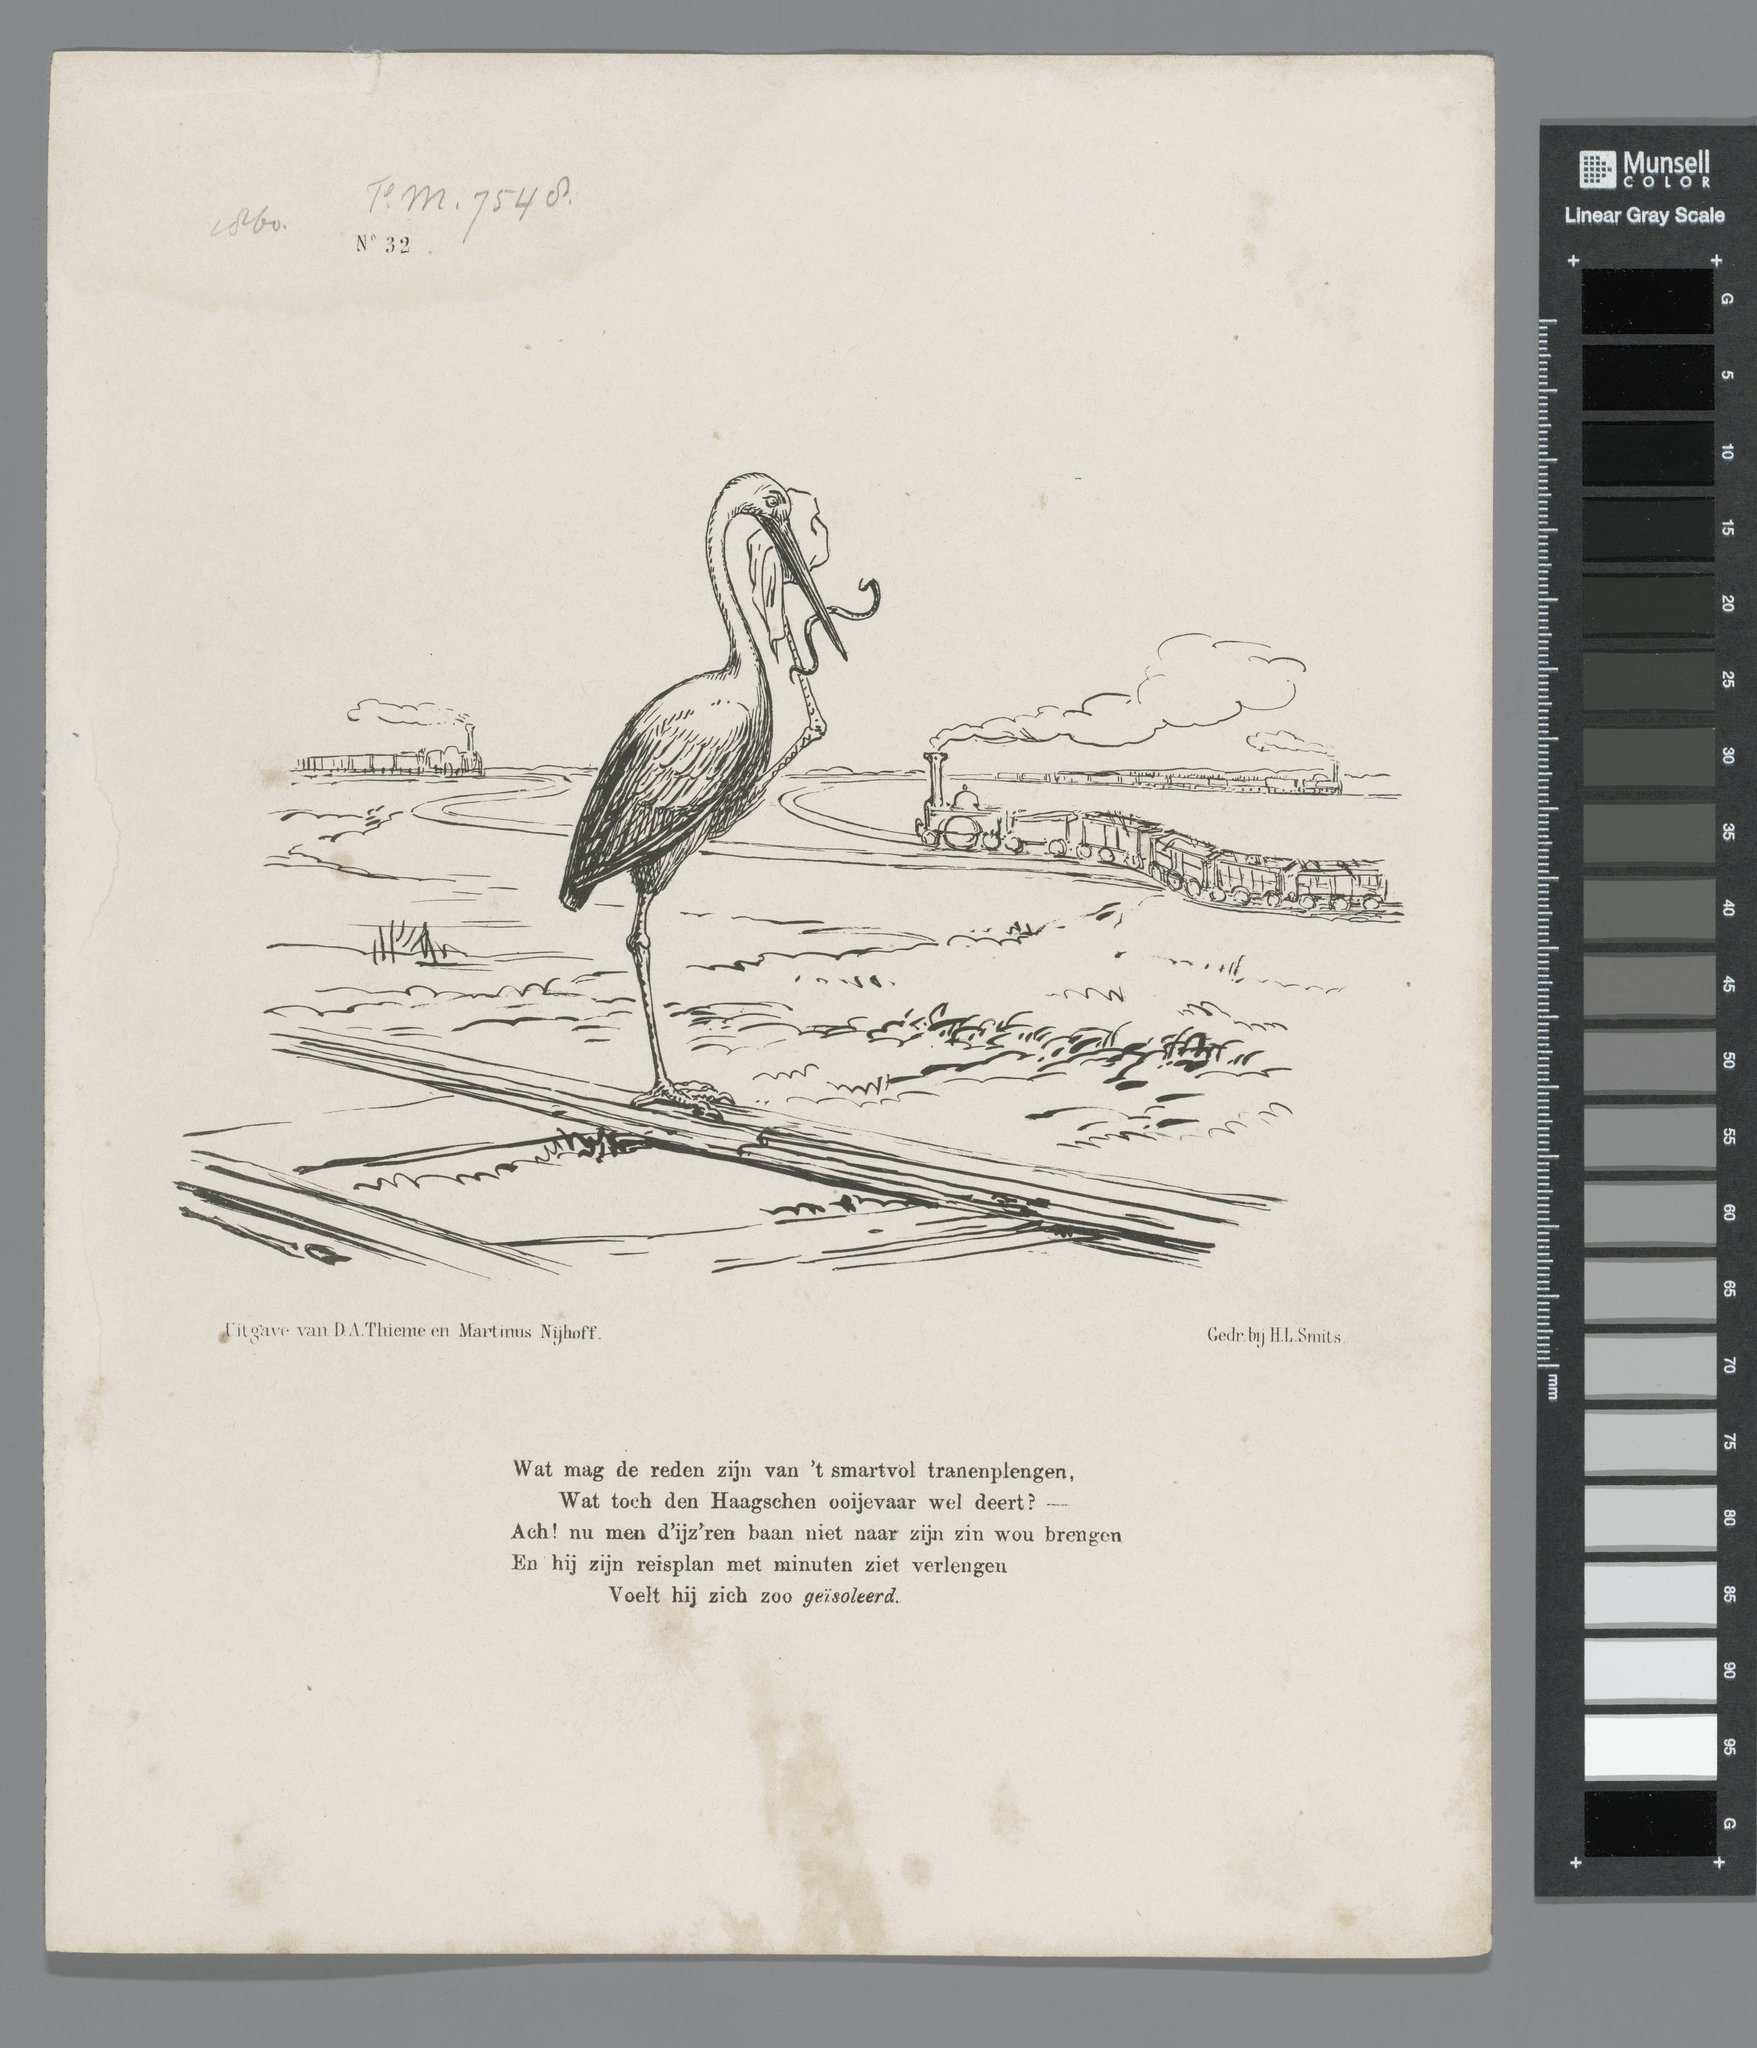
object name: cartoon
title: Spotprent op de richting van de spoorweg bij Den Haag, 1860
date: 1860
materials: paper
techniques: lithograph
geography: the hague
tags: shore-birds and wading-birds: stork, weeping, railway, train, the hague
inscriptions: collector's mark: Lugt 2228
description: Spotprent op de richting van de spoorweg die Den Haag met het spoorwegnet zou verbinden. Een ooievaar staat te huilen bij de spoorlijnen. Plaat verschenen bij het weekblad De Nederlandsche Spectator, nr. 32, 11 augustus 1860.